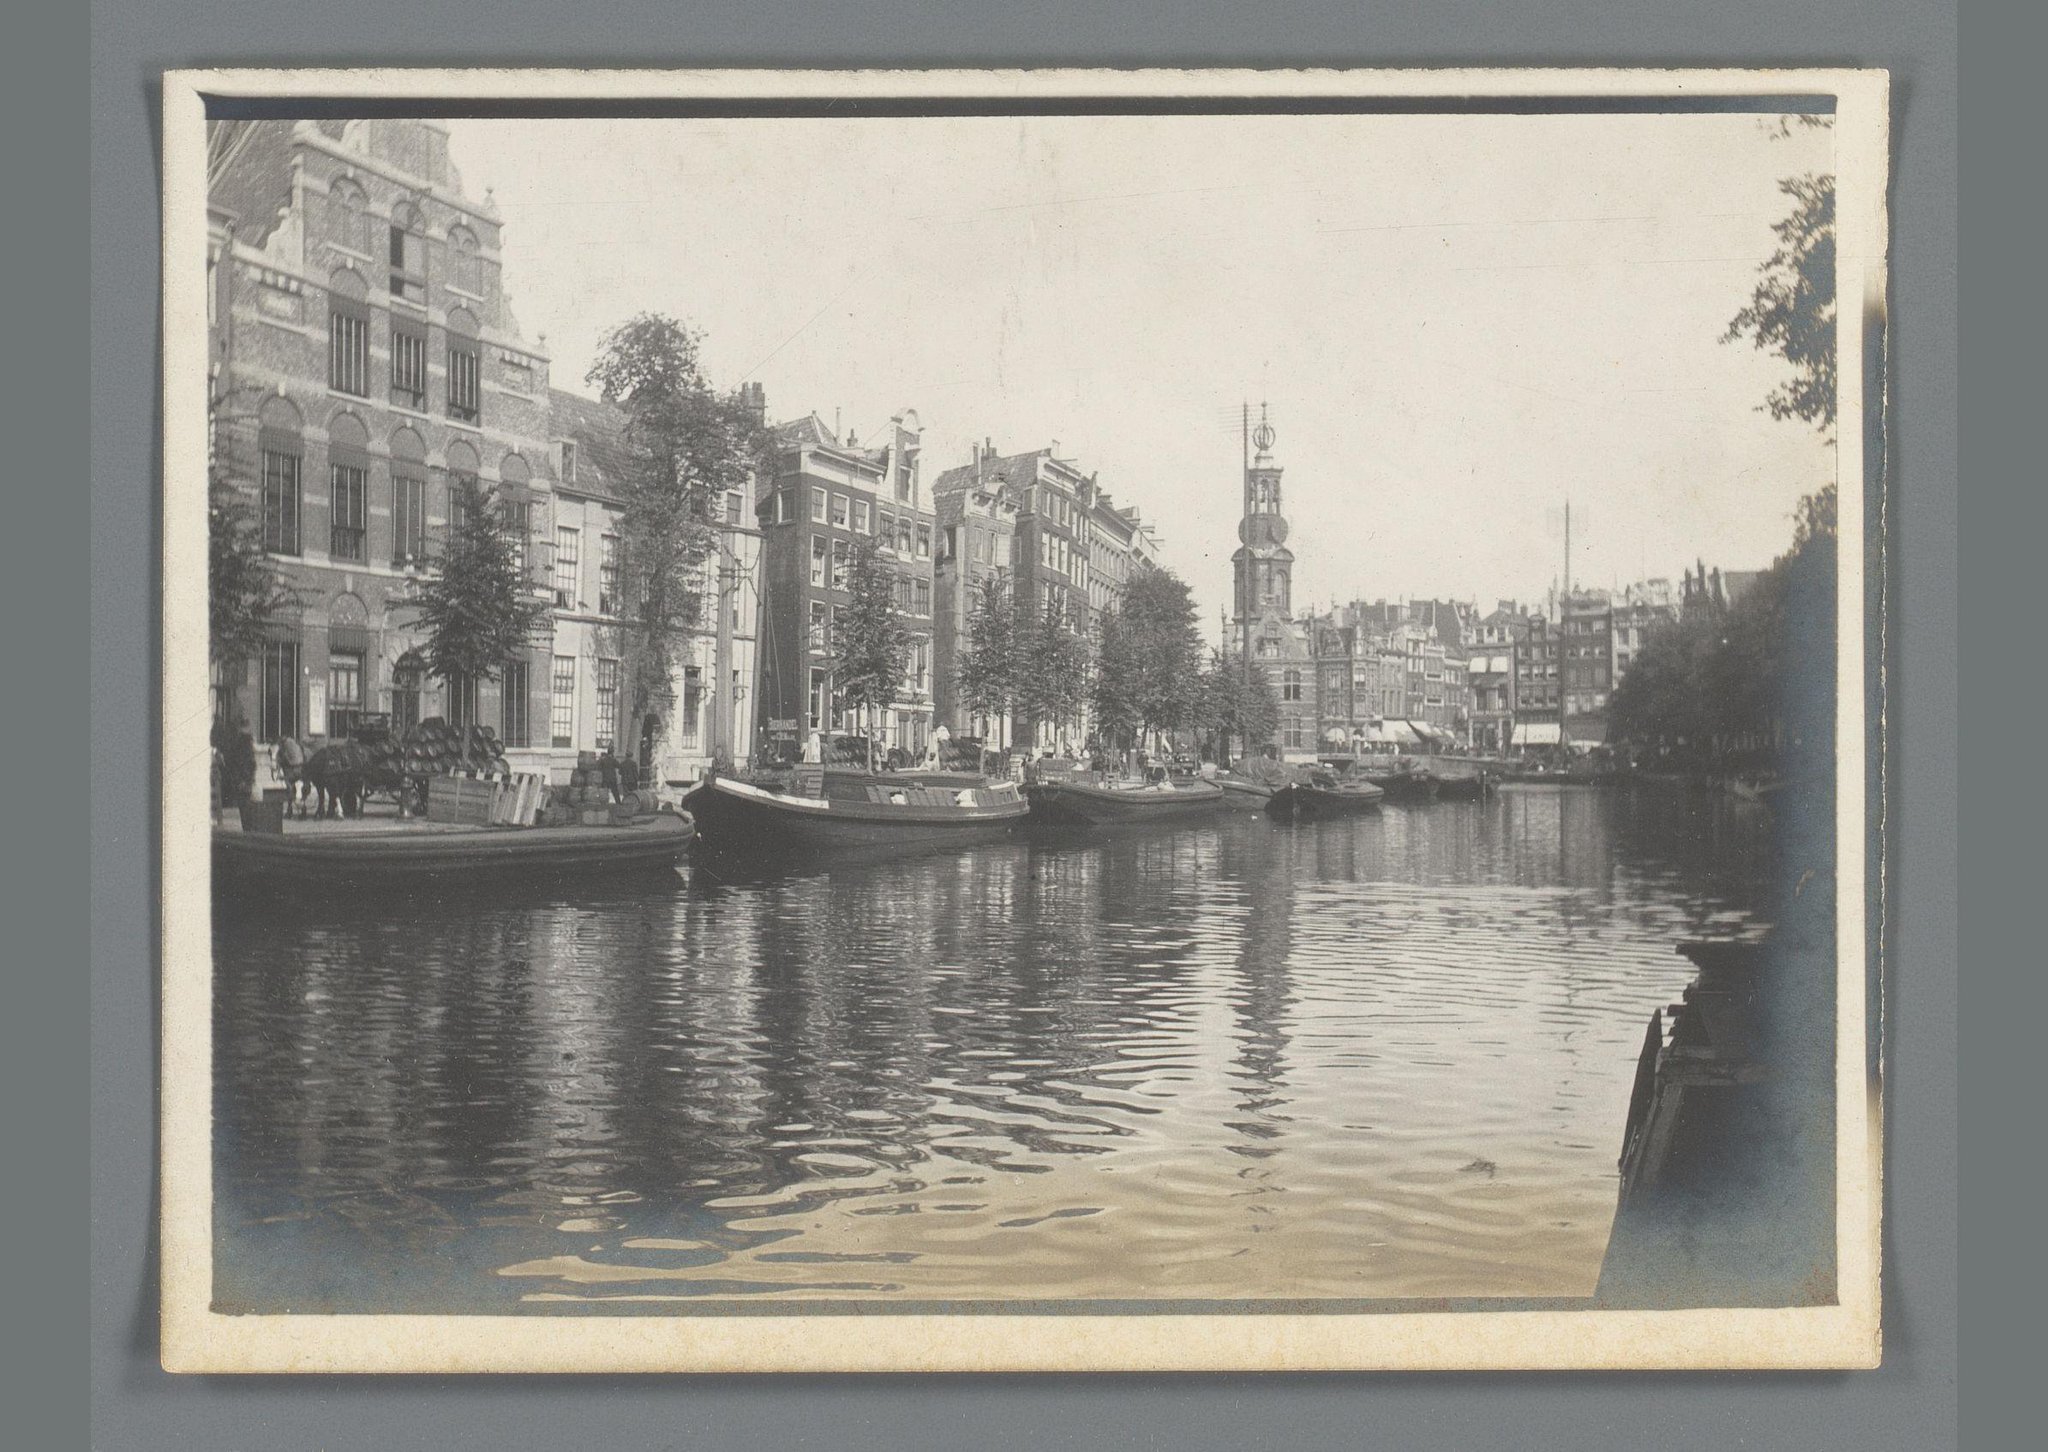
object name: photograph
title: Gezicht op de Singel, op de achtergrond de Munttoren, Amsterdam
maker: willem de jong (fotograaf)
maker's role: arts, fotograaf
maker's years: 1864-1918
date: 1895-1918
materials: paper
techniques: gelatin silver print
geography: amsterdam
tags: defence of fortification or city, canal